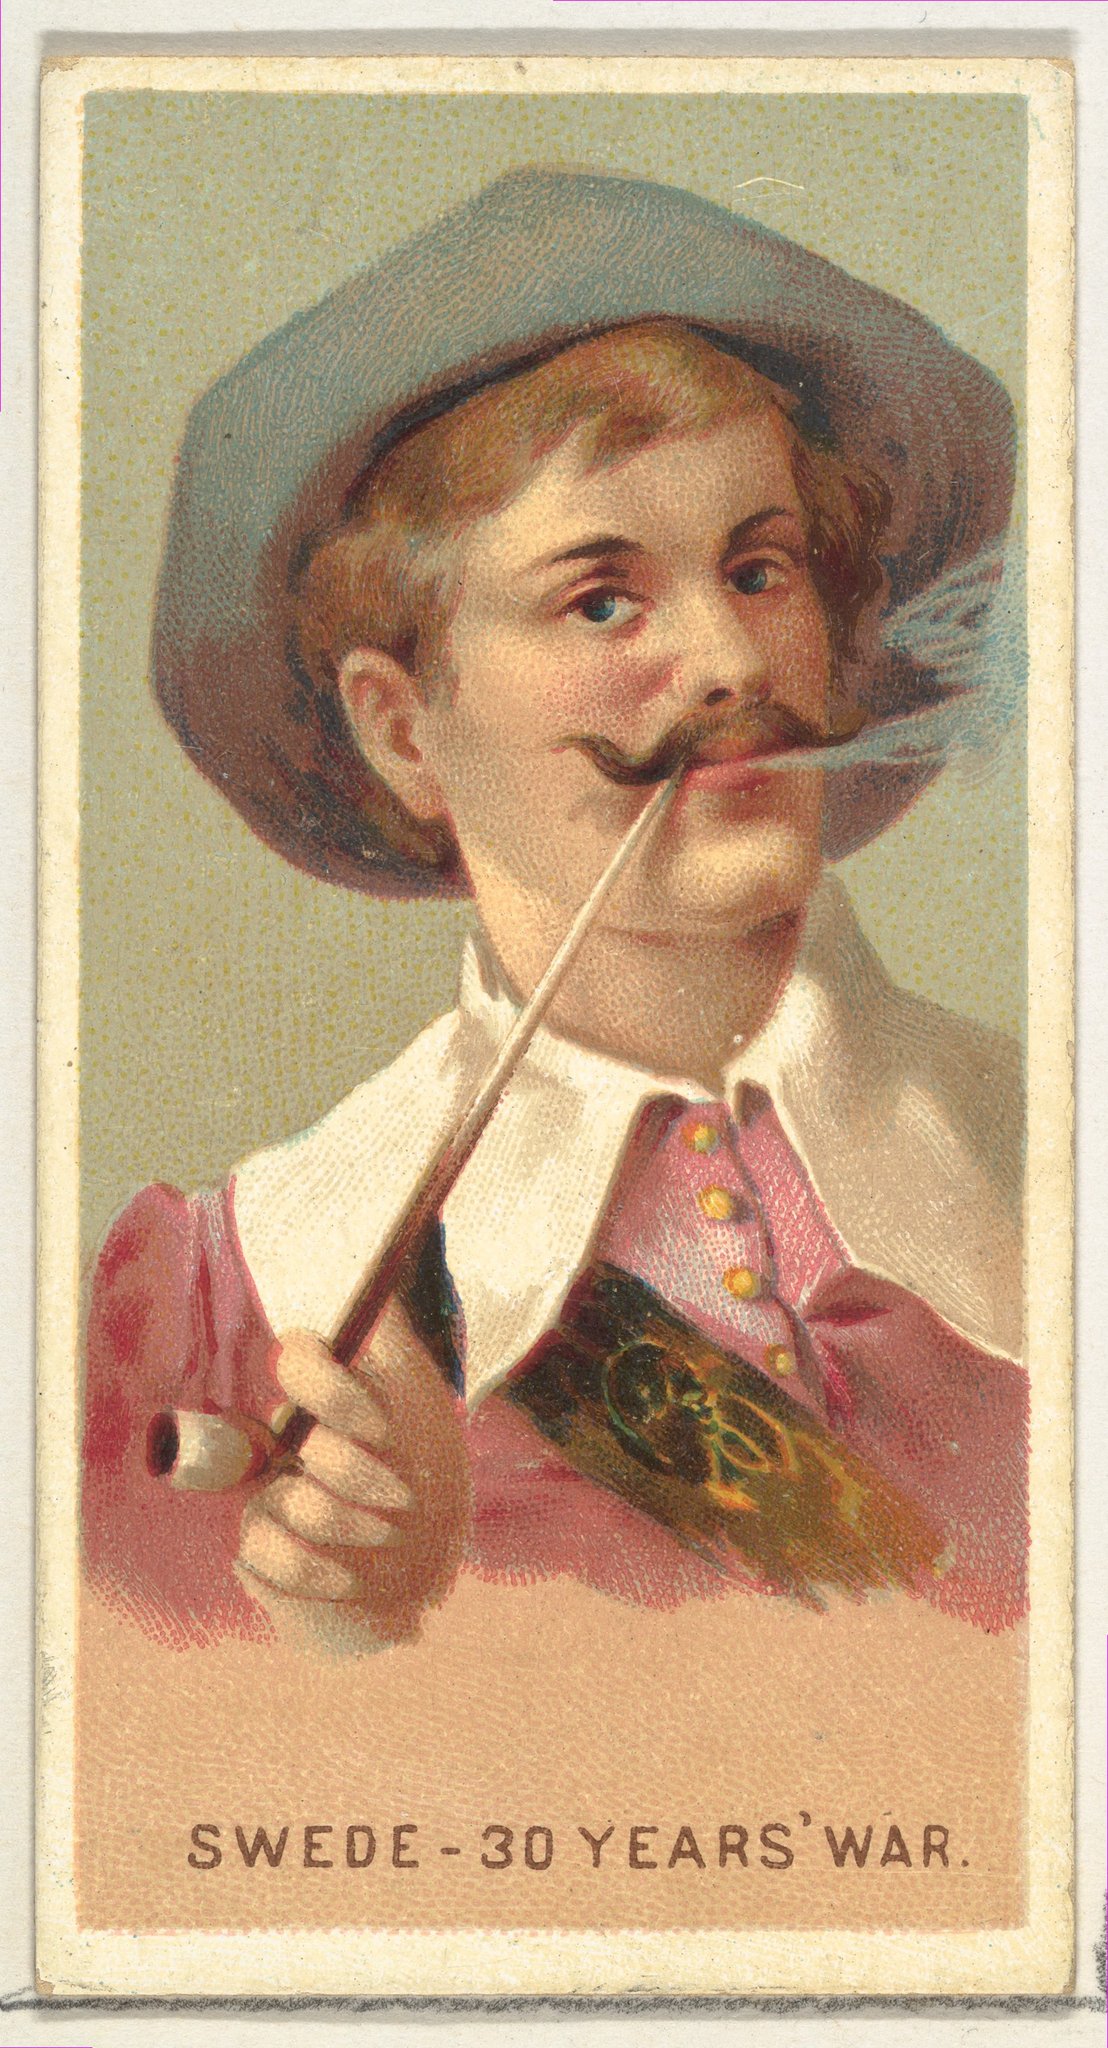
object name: print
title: Swede in the 30 Years War, from World's Smokers series (N33) for Allen & Ginter Cigarettes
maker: allen & ginter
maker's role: publisher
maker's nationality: american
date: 1888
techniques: color lithograph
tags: men,smoking